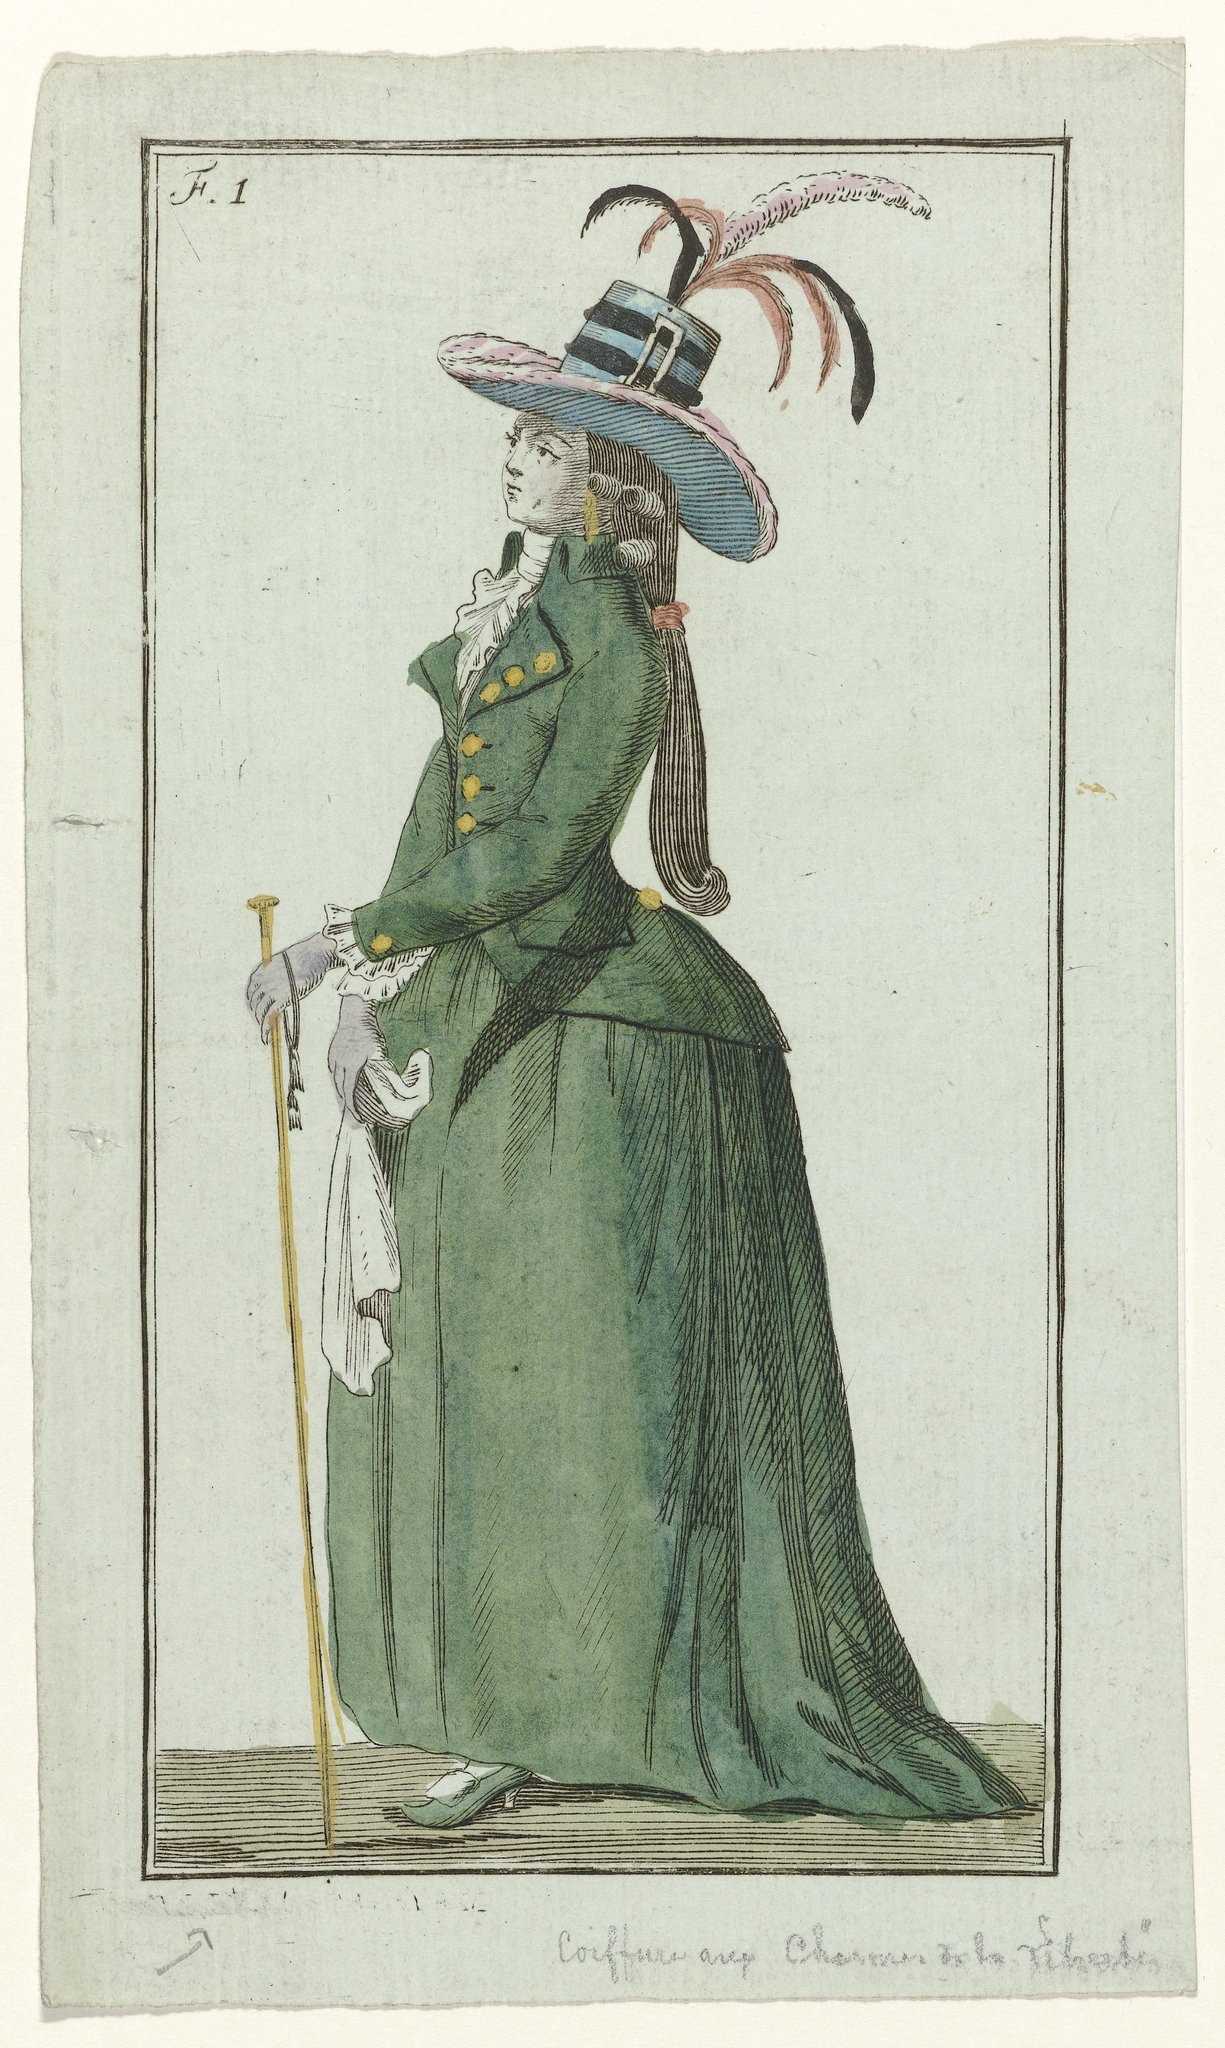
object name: fashion print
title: Magasin des Modes Nouvelles Françaises et Anglaises, kopie naar Pl.1, 10 mars 1787, F. 1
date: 1787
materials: paper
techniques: engraving, hand coloring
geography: lille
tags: clothing for the upper part of the body (+ women's clothes), ear-rings (+ women's clothes), handkerchief (+ women's clothes), walking-stick, staff, cane (+ women's clothes), head-gear (+ women's clothes), fashion plates, shoes, sandals (+ women's clothes), skirt (+ women's clothes), neck-gear ~ clothing (+ women's clothes)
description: Staande vrouw gekleed in een jasje met opstaande kraag en schootje, op een rok met sleep, beiden van laken. Gerimpelde jabot (?) en manchetten. Het haar in een lange staart. Accessoires: hoed met veren en afgezet met bont (?), oorbel, handschoenen, wandelstok met knop, zakdoek, schoen met puntige neus en hak. De prent is een kopie naar Pl.1 van het 12e Cahier, 2e année, uit de serie Magasin des Modes Nouvelles Françaises et Anglaises. De serie bestaat uit 172 modeprenten, uitgegeven door Buisson, Parijs, 20 november 1786 - 21 décembre 1789.